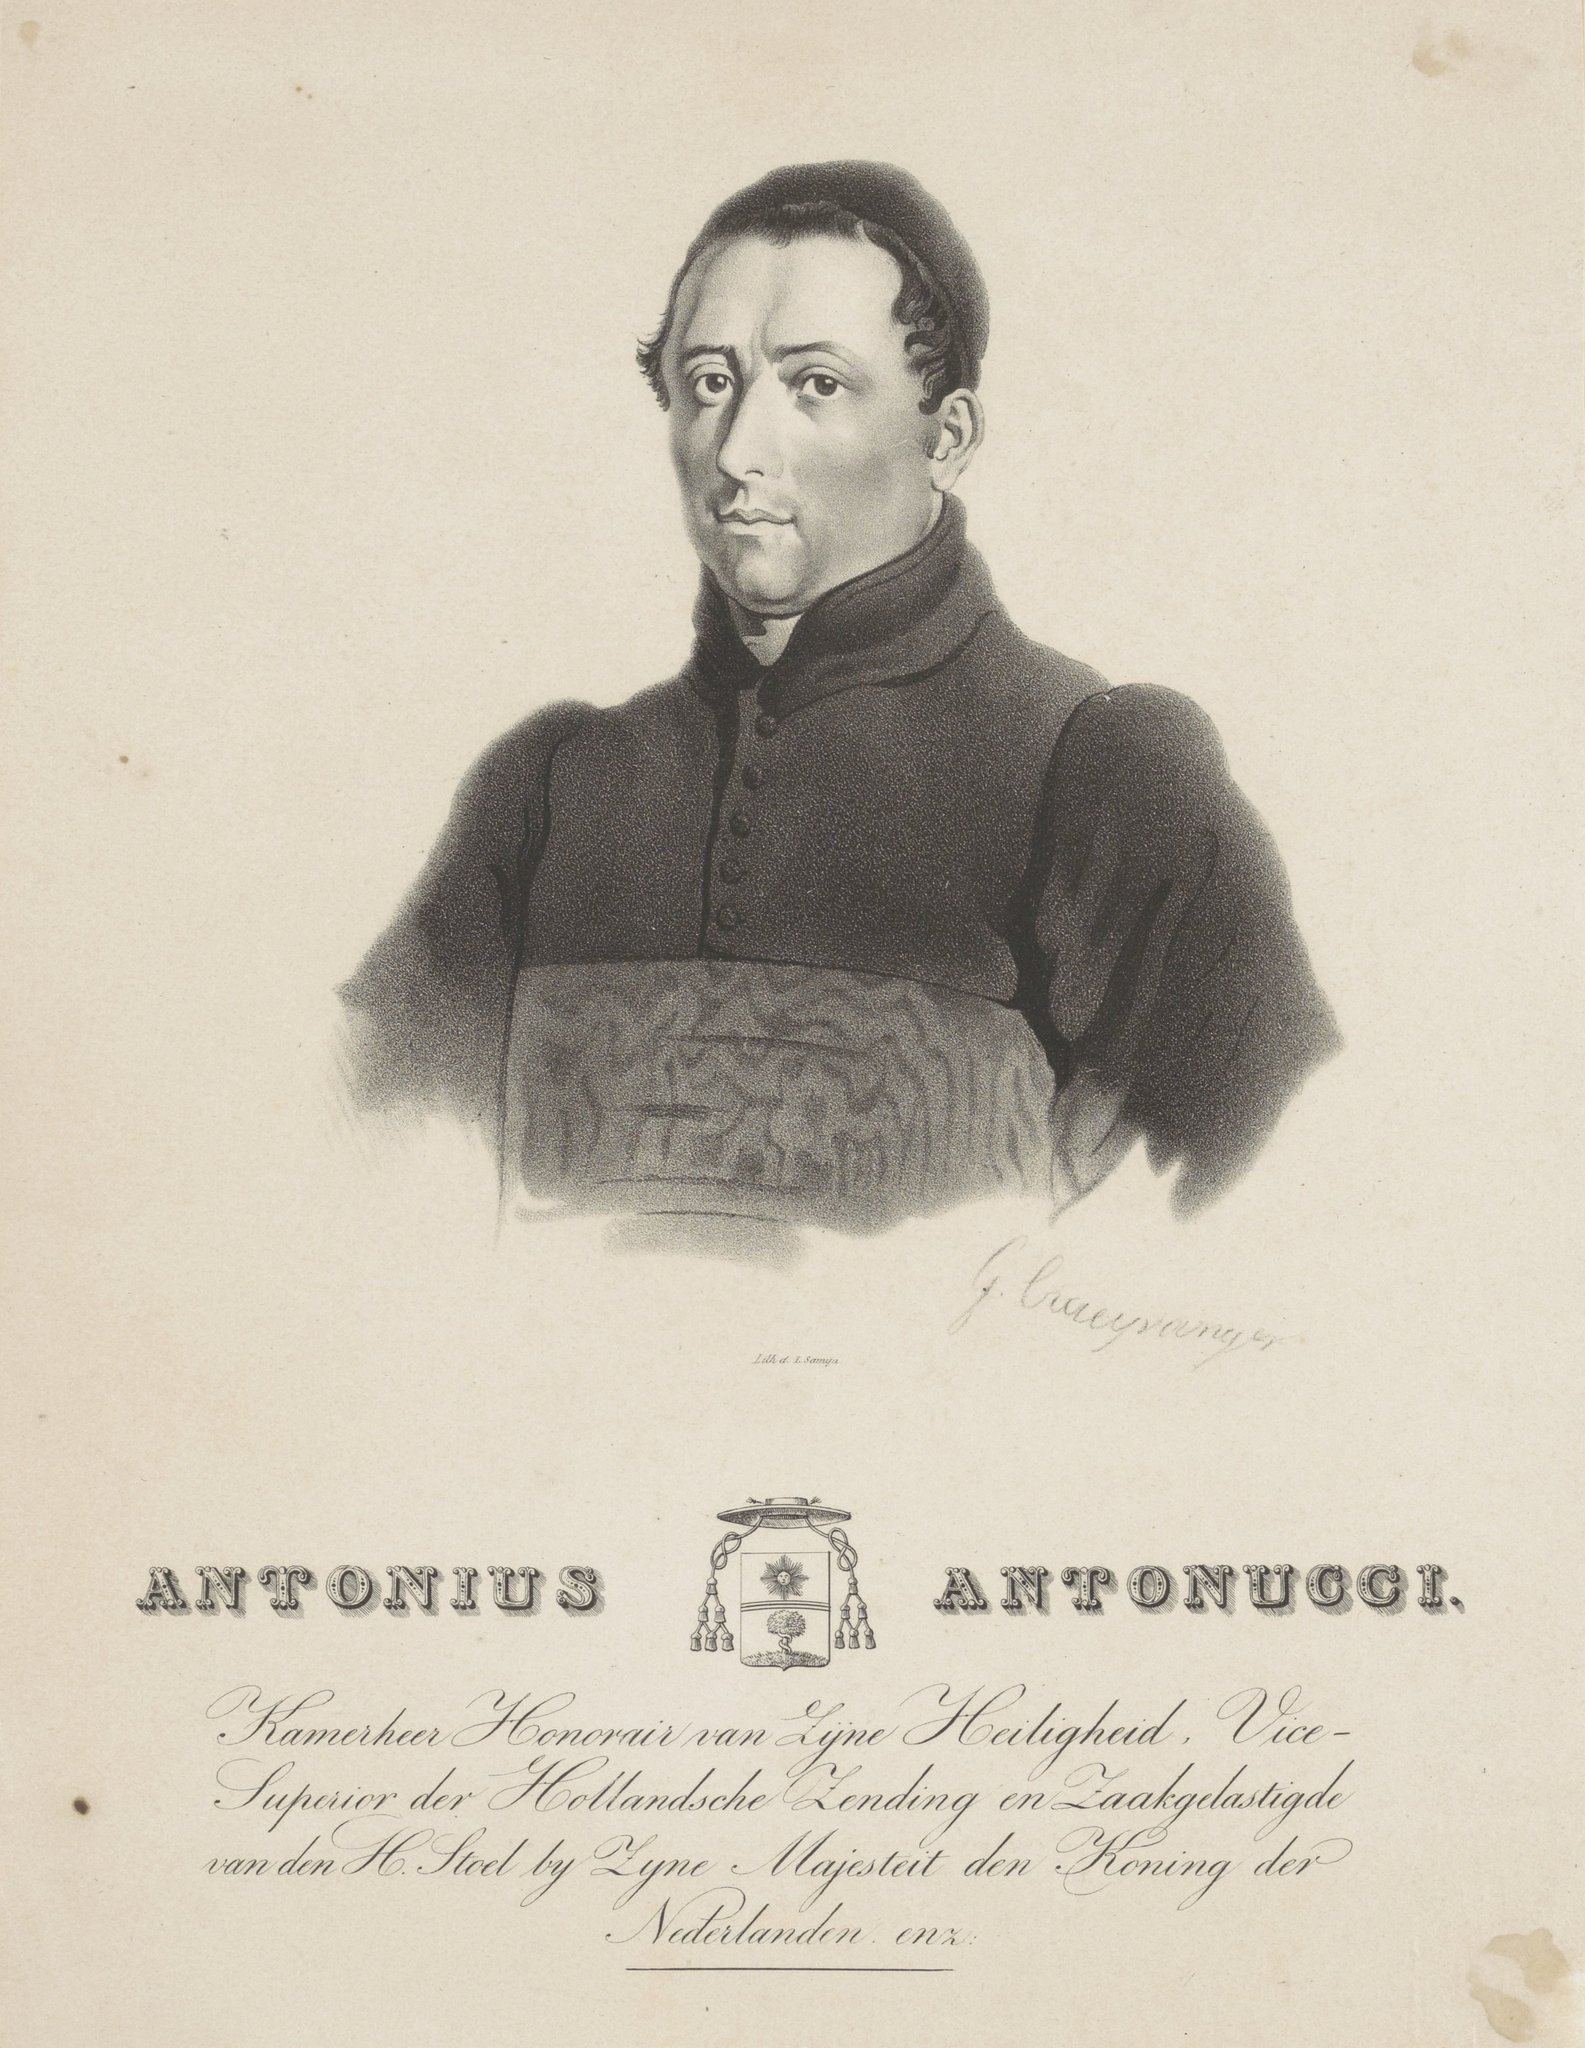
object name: print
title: Portret van Antonio Antonucci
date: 1834-1835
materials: paper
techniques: lithograph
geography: netherlands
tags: archbishop, bishop, etc. (roman catholic), historical persons (+ (full) bust portrait), armorial bearing, heraldry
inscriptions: collector's mark: Lugt 2228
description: De geportretteerde draagt een bisschoppelijk gewaad. Onder het portret zijn naam, wapen en signatuur.